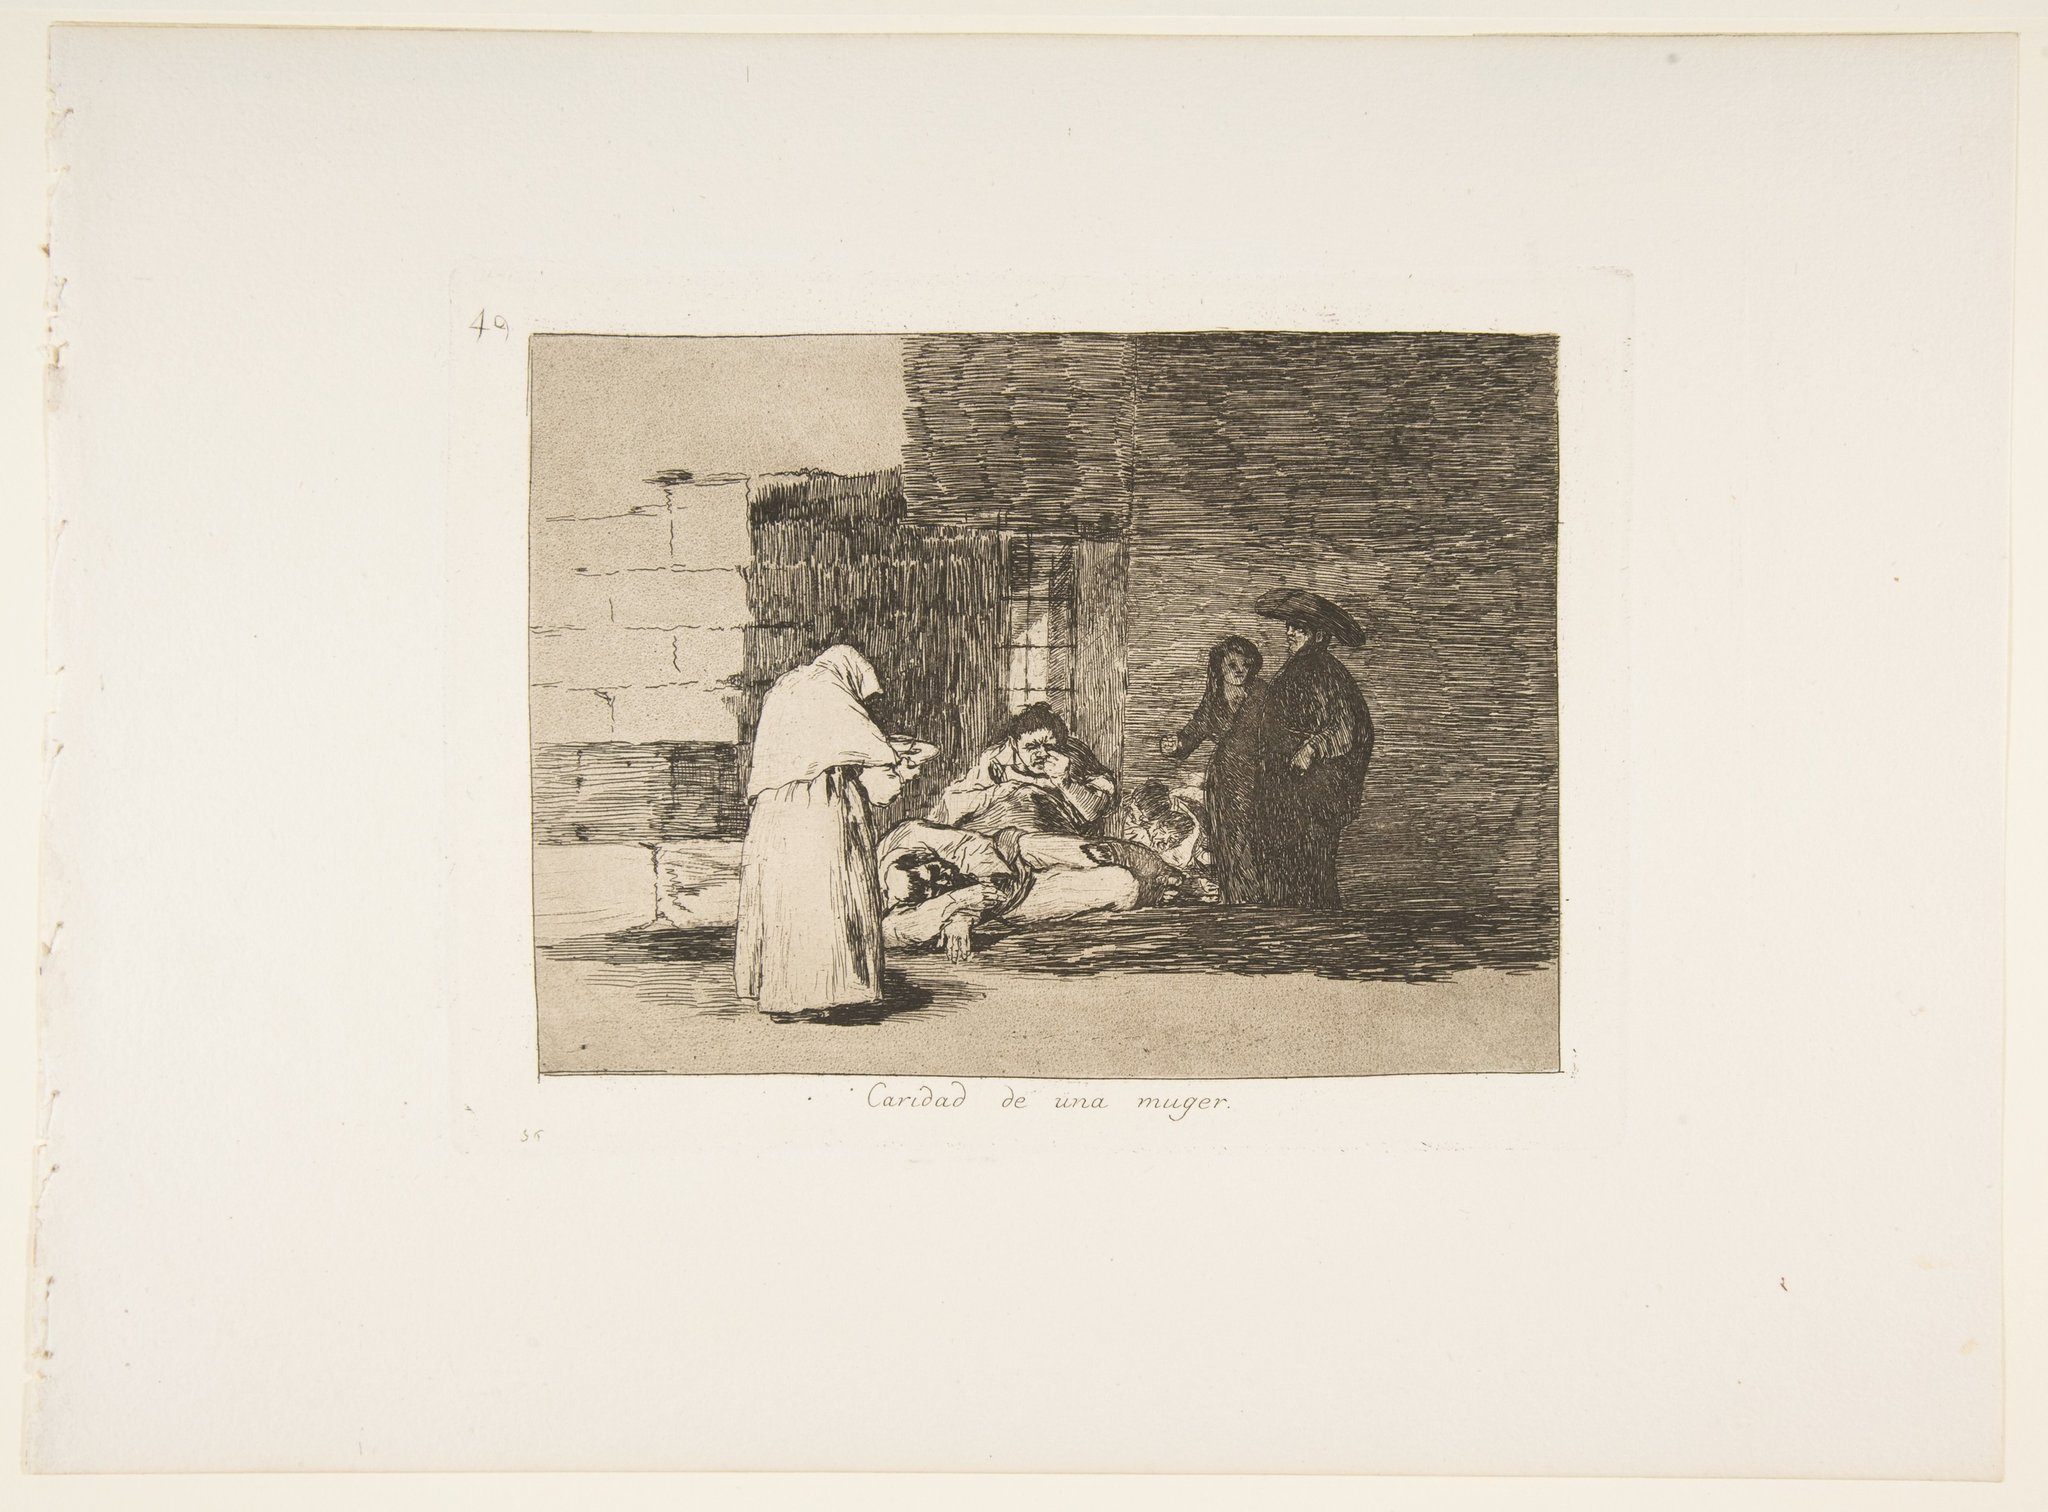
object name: print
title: Plate 49 from "The Disasters of War" (Los Desastres de la Guerra): 'A woman's charity' (Caridad de una muger)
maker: goya (francisco de goya y lucientes)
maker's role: artist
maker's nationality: spanish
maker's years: 1746-1828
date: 1811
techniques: engraving, etching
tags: men,women